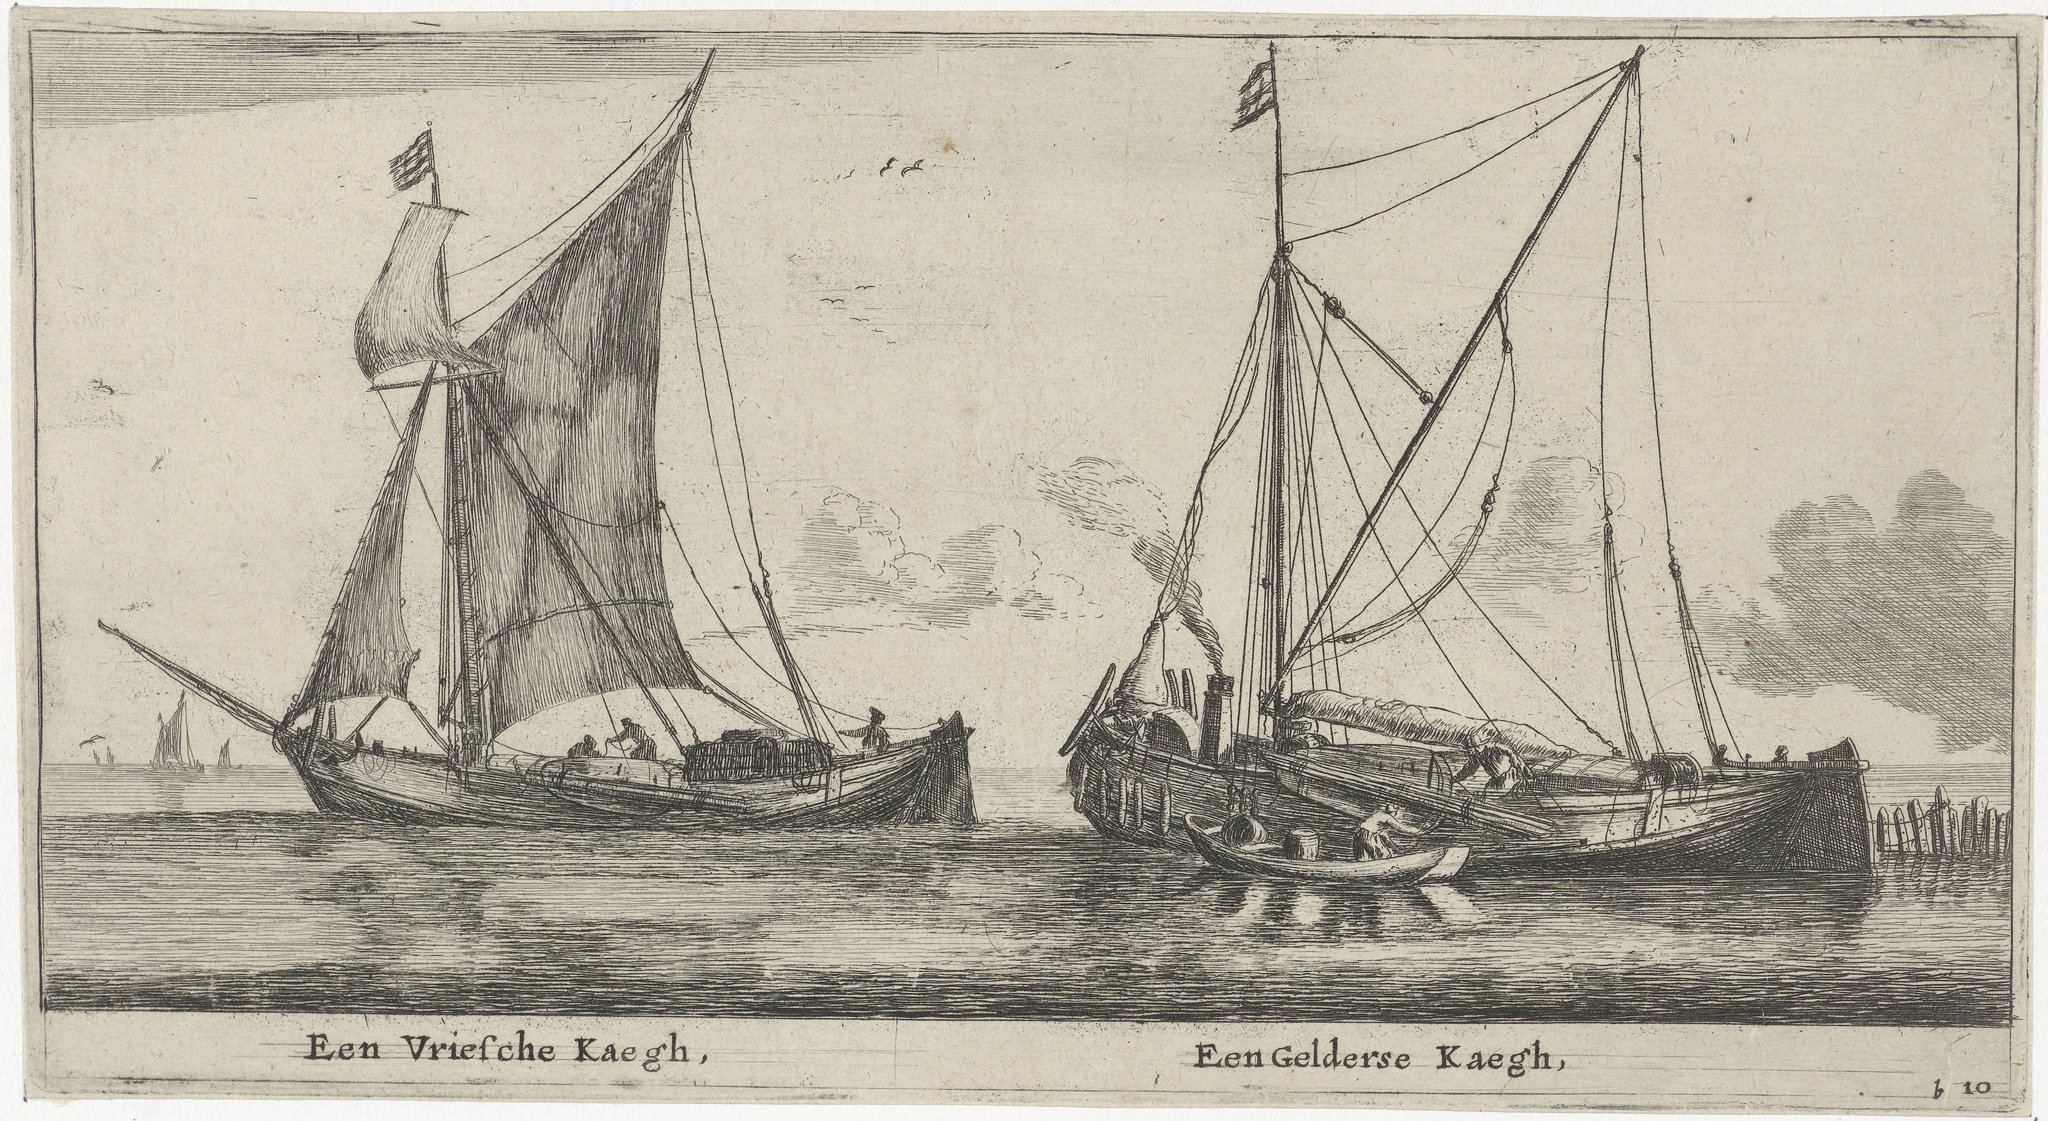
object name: print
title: Twee schepen: een Friese kaag en een Gelderse kaag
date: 1652-1654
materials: paper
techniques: drypoint, etching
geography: netherlands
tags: sailing-ship, sailing-boat (with name)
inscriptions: collector's mark: Lugt 12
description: Een Friese en een Gelderse kaag op het water.